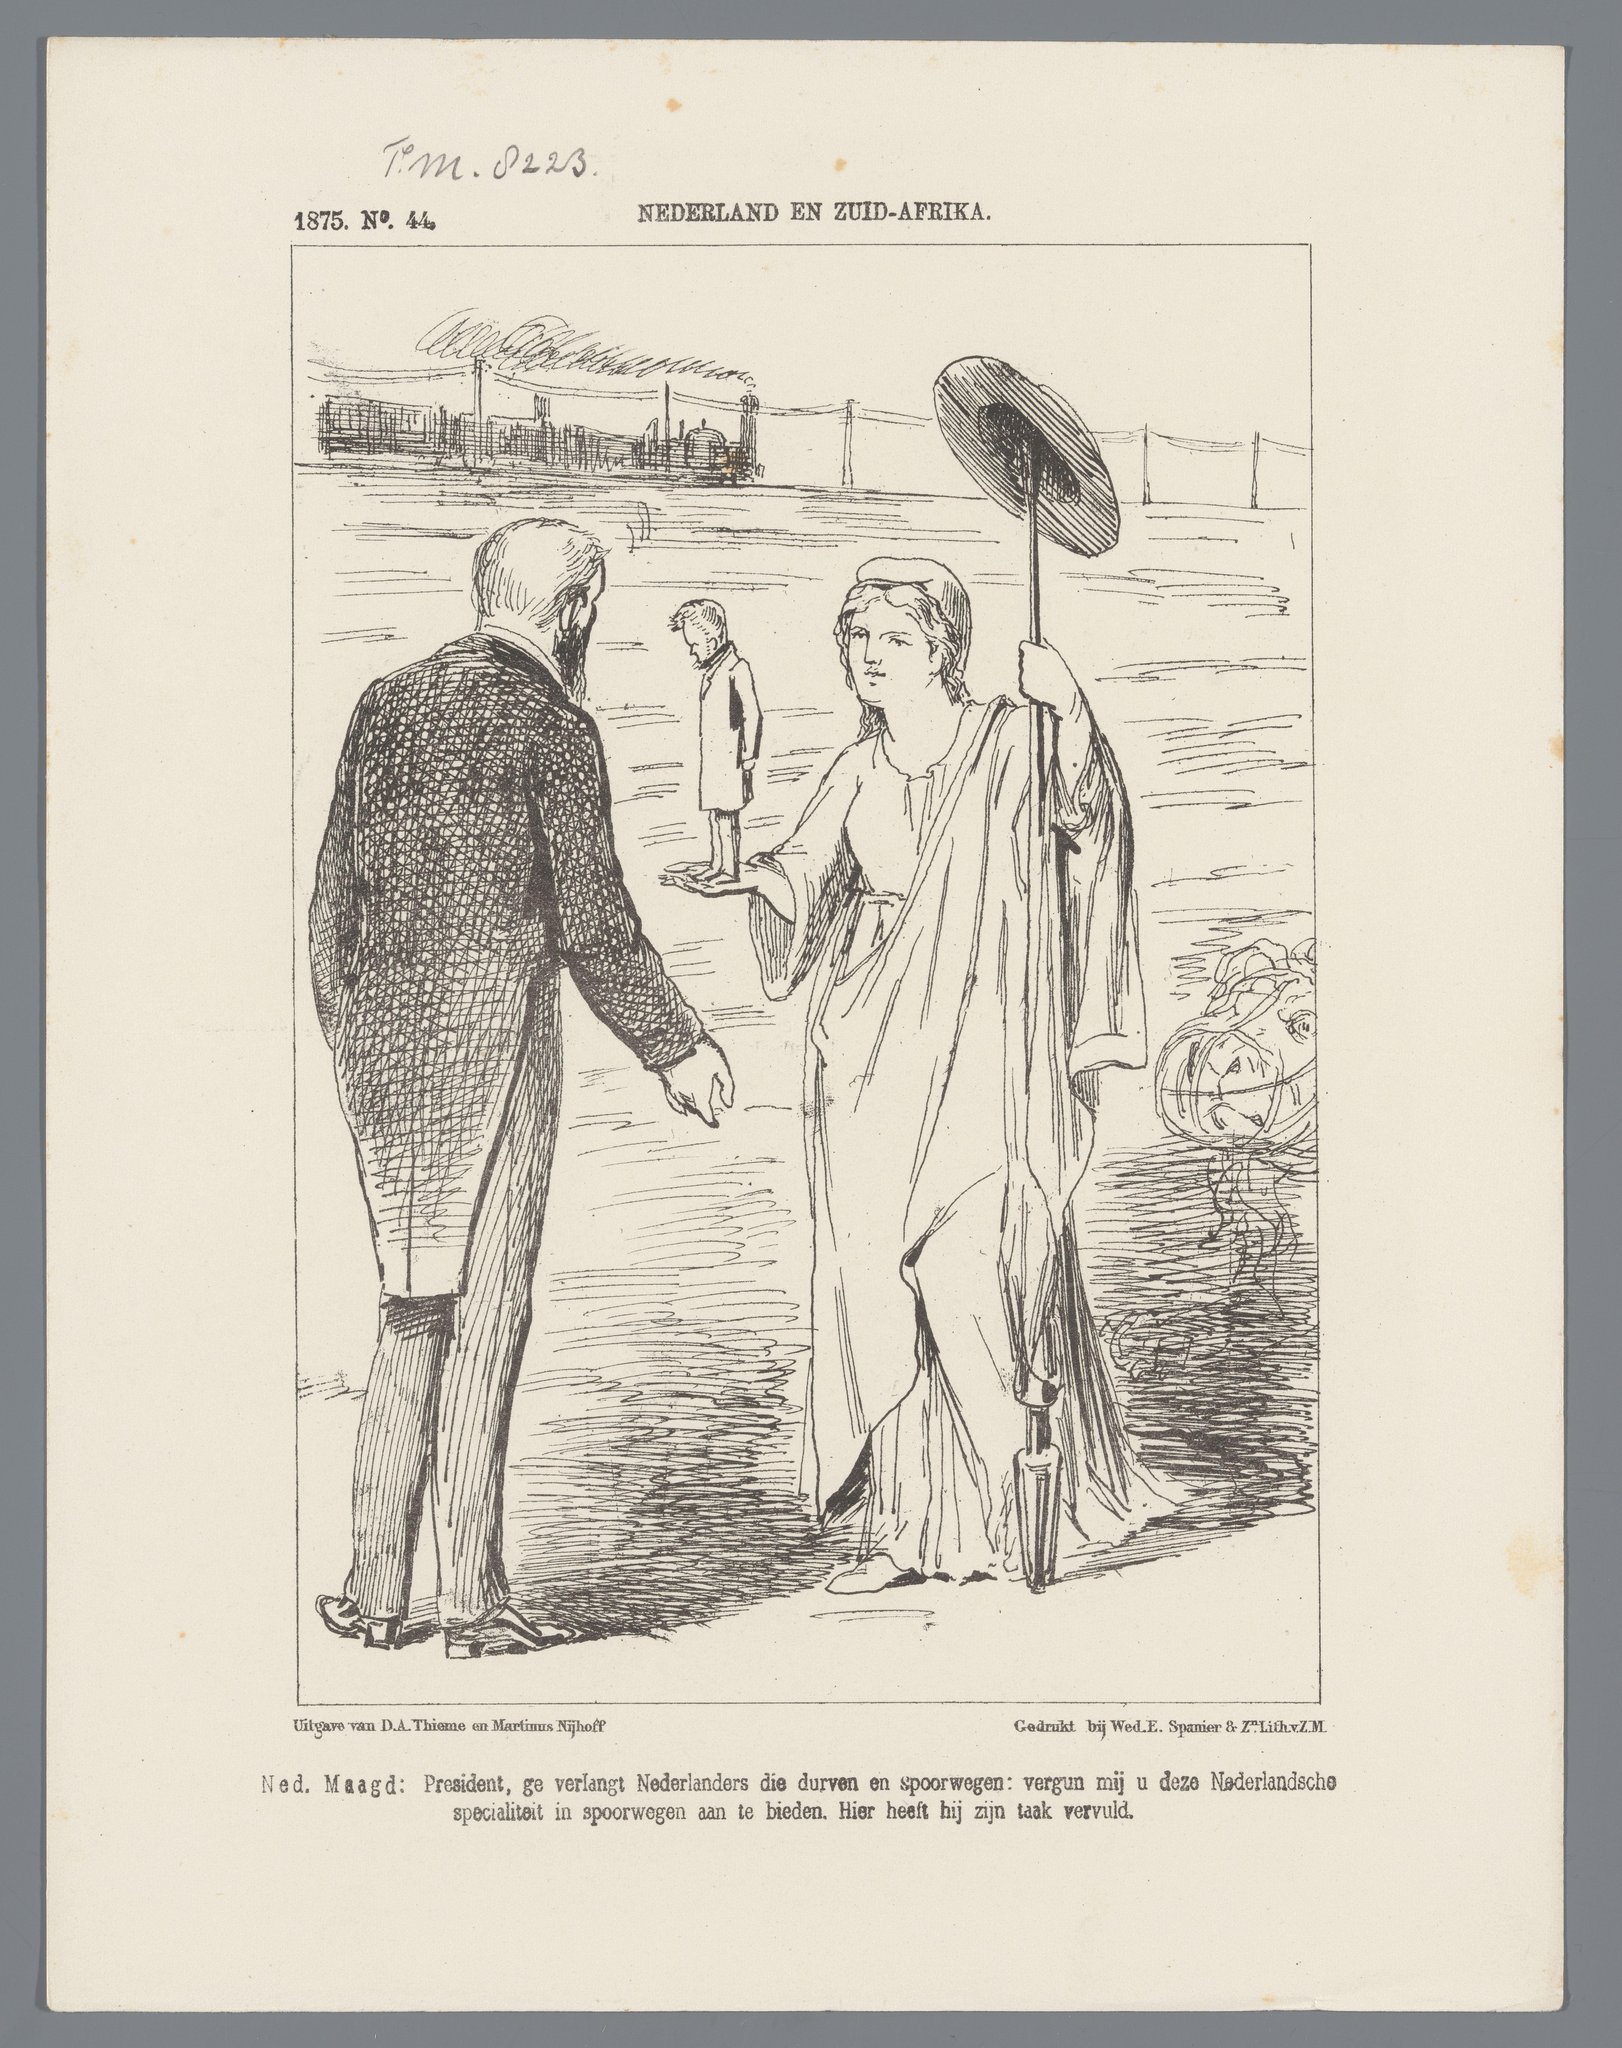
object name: cartoon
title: Nederland en Zuid-Afrika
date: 1875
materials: paper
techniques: lithograph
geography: netherlands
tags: amsterdam, politician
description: Spotprent over het door Nederland laten aanleggen van spoorwegen in Zuid-Afrika, 1875. Minister Heemskerk en president Burgers. Plaat verschenen bij het weekblad De Nederlandsche Spectator, nr. 44, 1875.